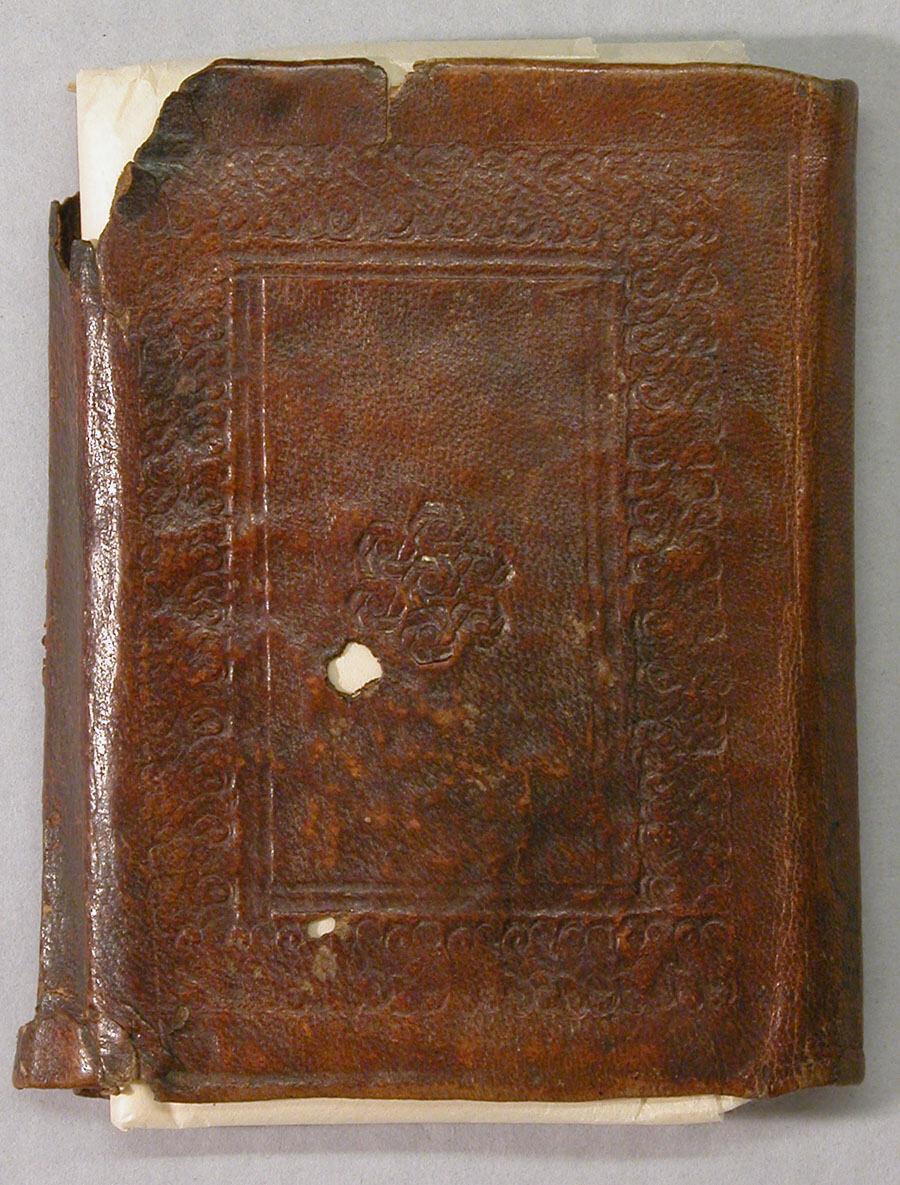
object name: bookbinding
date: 1201-1400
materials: leather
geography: north africa